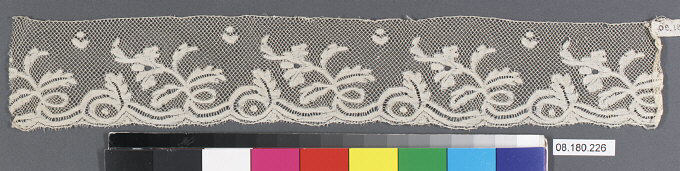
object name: piece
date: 1801-1900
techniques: lace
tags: leaves